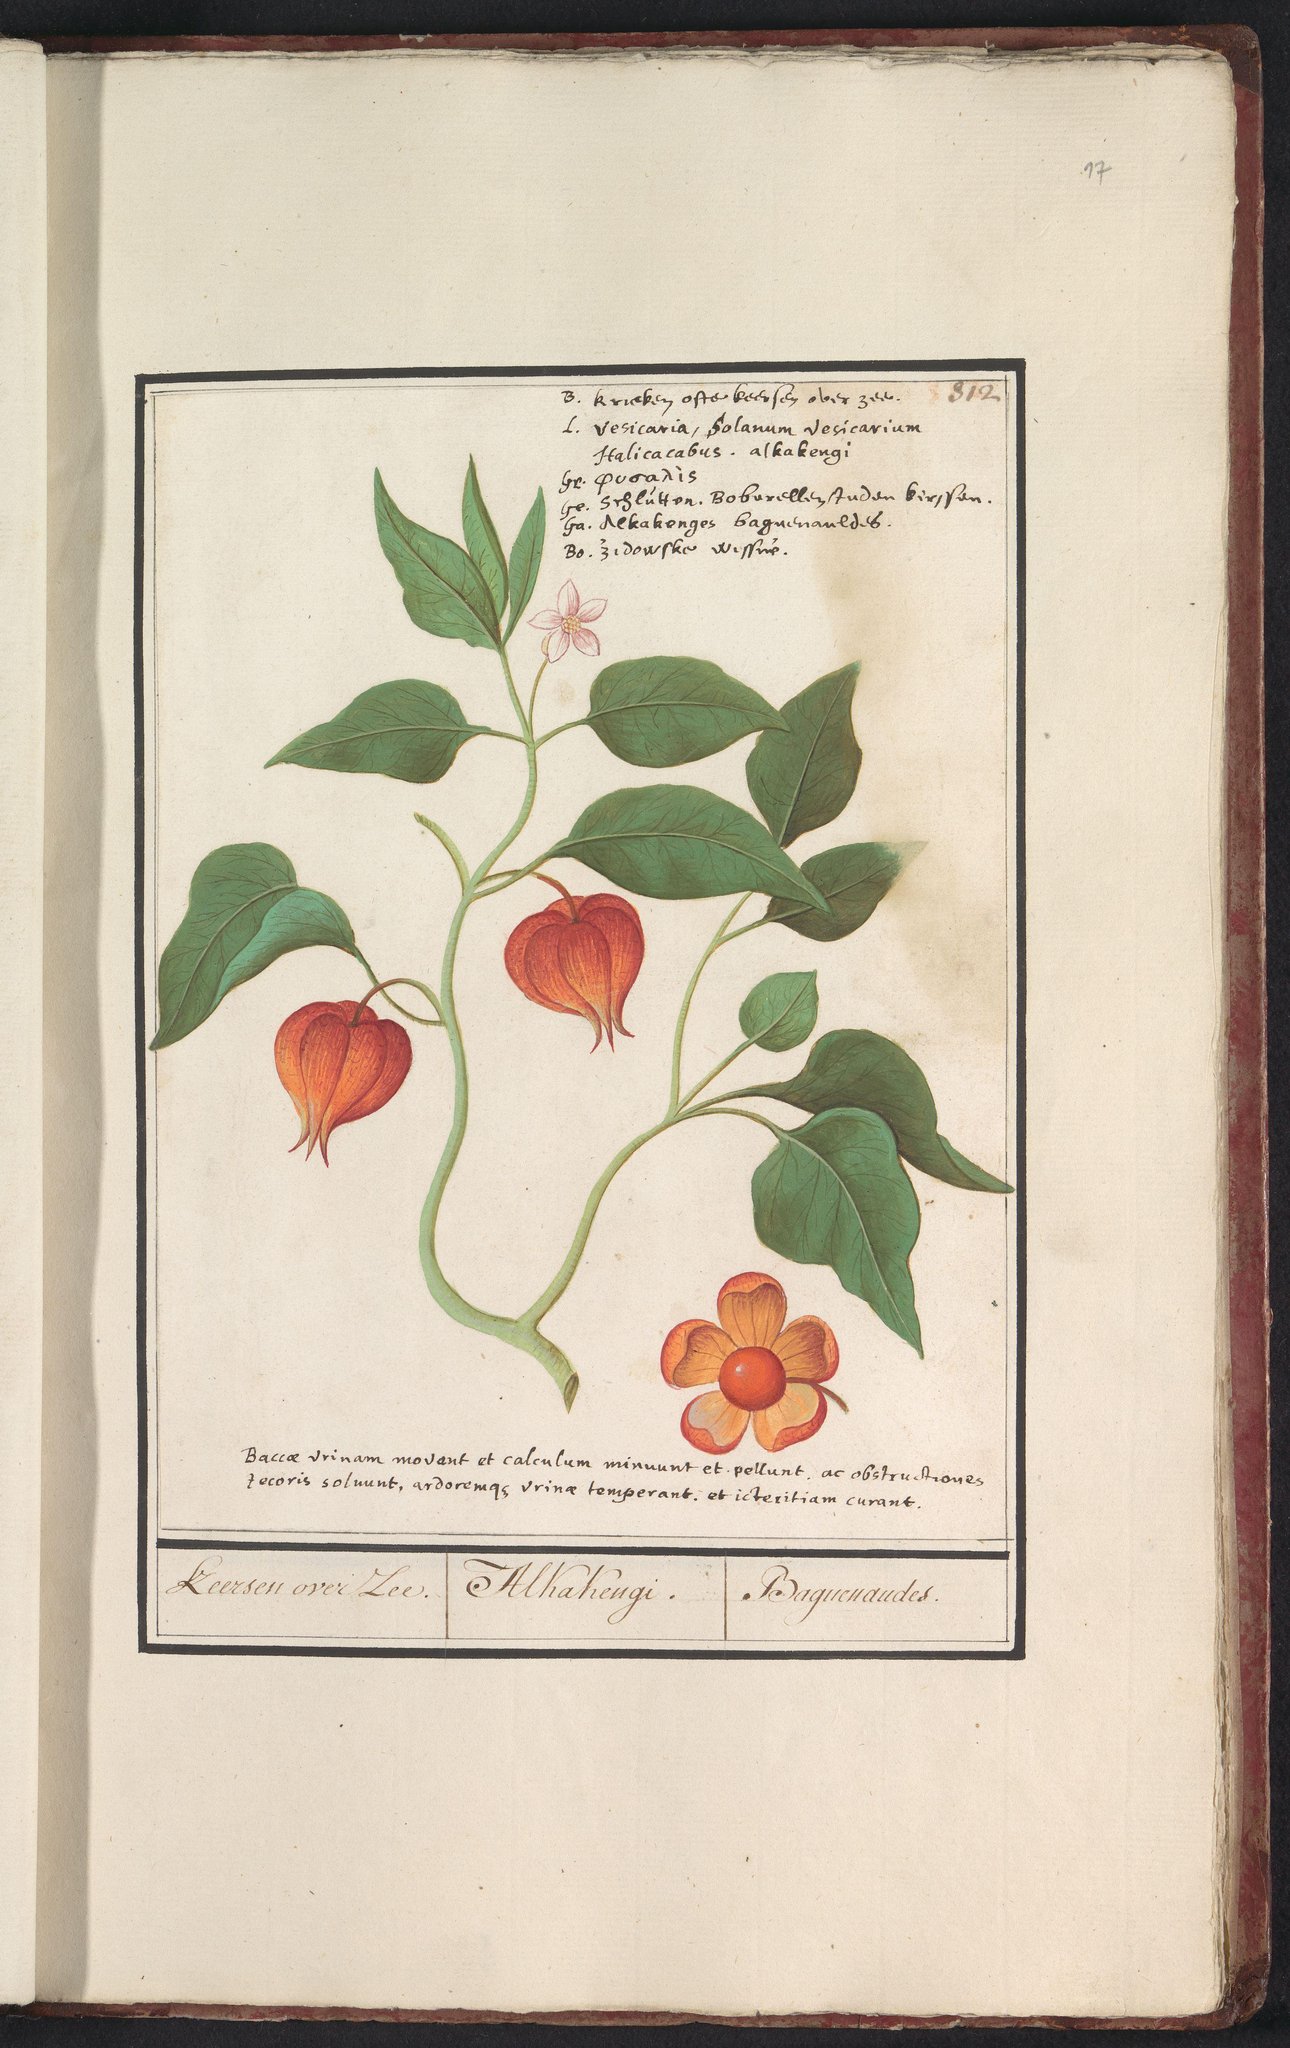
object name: drawing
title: Cape Gooseberry or Goldenberry (Physalis peruviana)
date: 1596-1610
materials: chalk, paint, ink, paper, watercolor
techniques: brush, pen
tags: flowers: physalis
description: The fact that the Historia Naturalis albums were sold only three times in four centuries accounts for the excellent condition of the individual drawings. The colours – like the deep orange in this sheet – are as pristine as the day they were applied. This gooseberry may be one of the many botanical drawings in the albums made by the Delft floral painter Elias Verhulst, from whom De Boodt commissioned around 200 drawings.